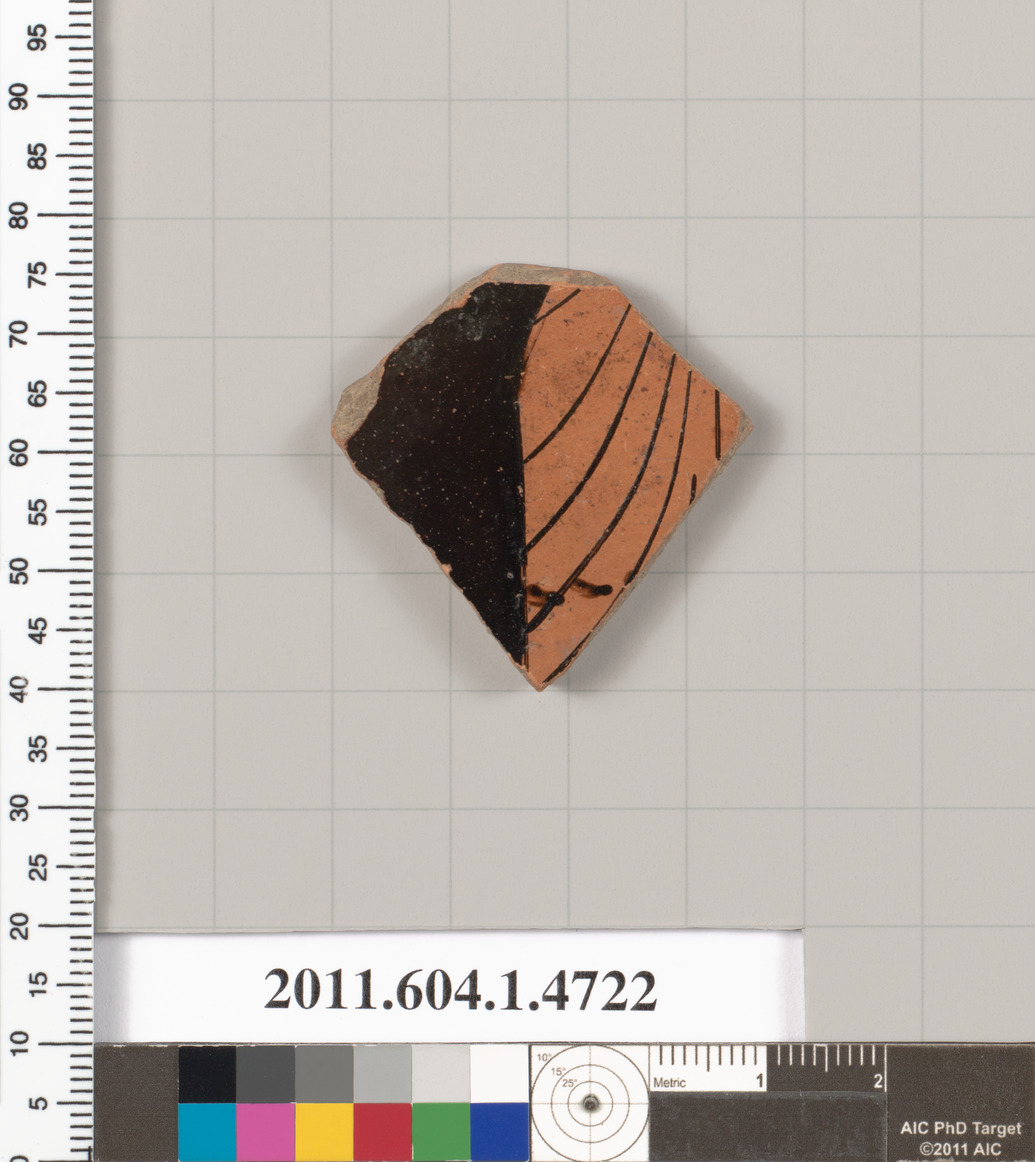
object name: kylix fragment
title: Terracotta fragment of a kylix (drinking cup)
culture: greek, attic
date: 500-480 BCE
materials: terracotta